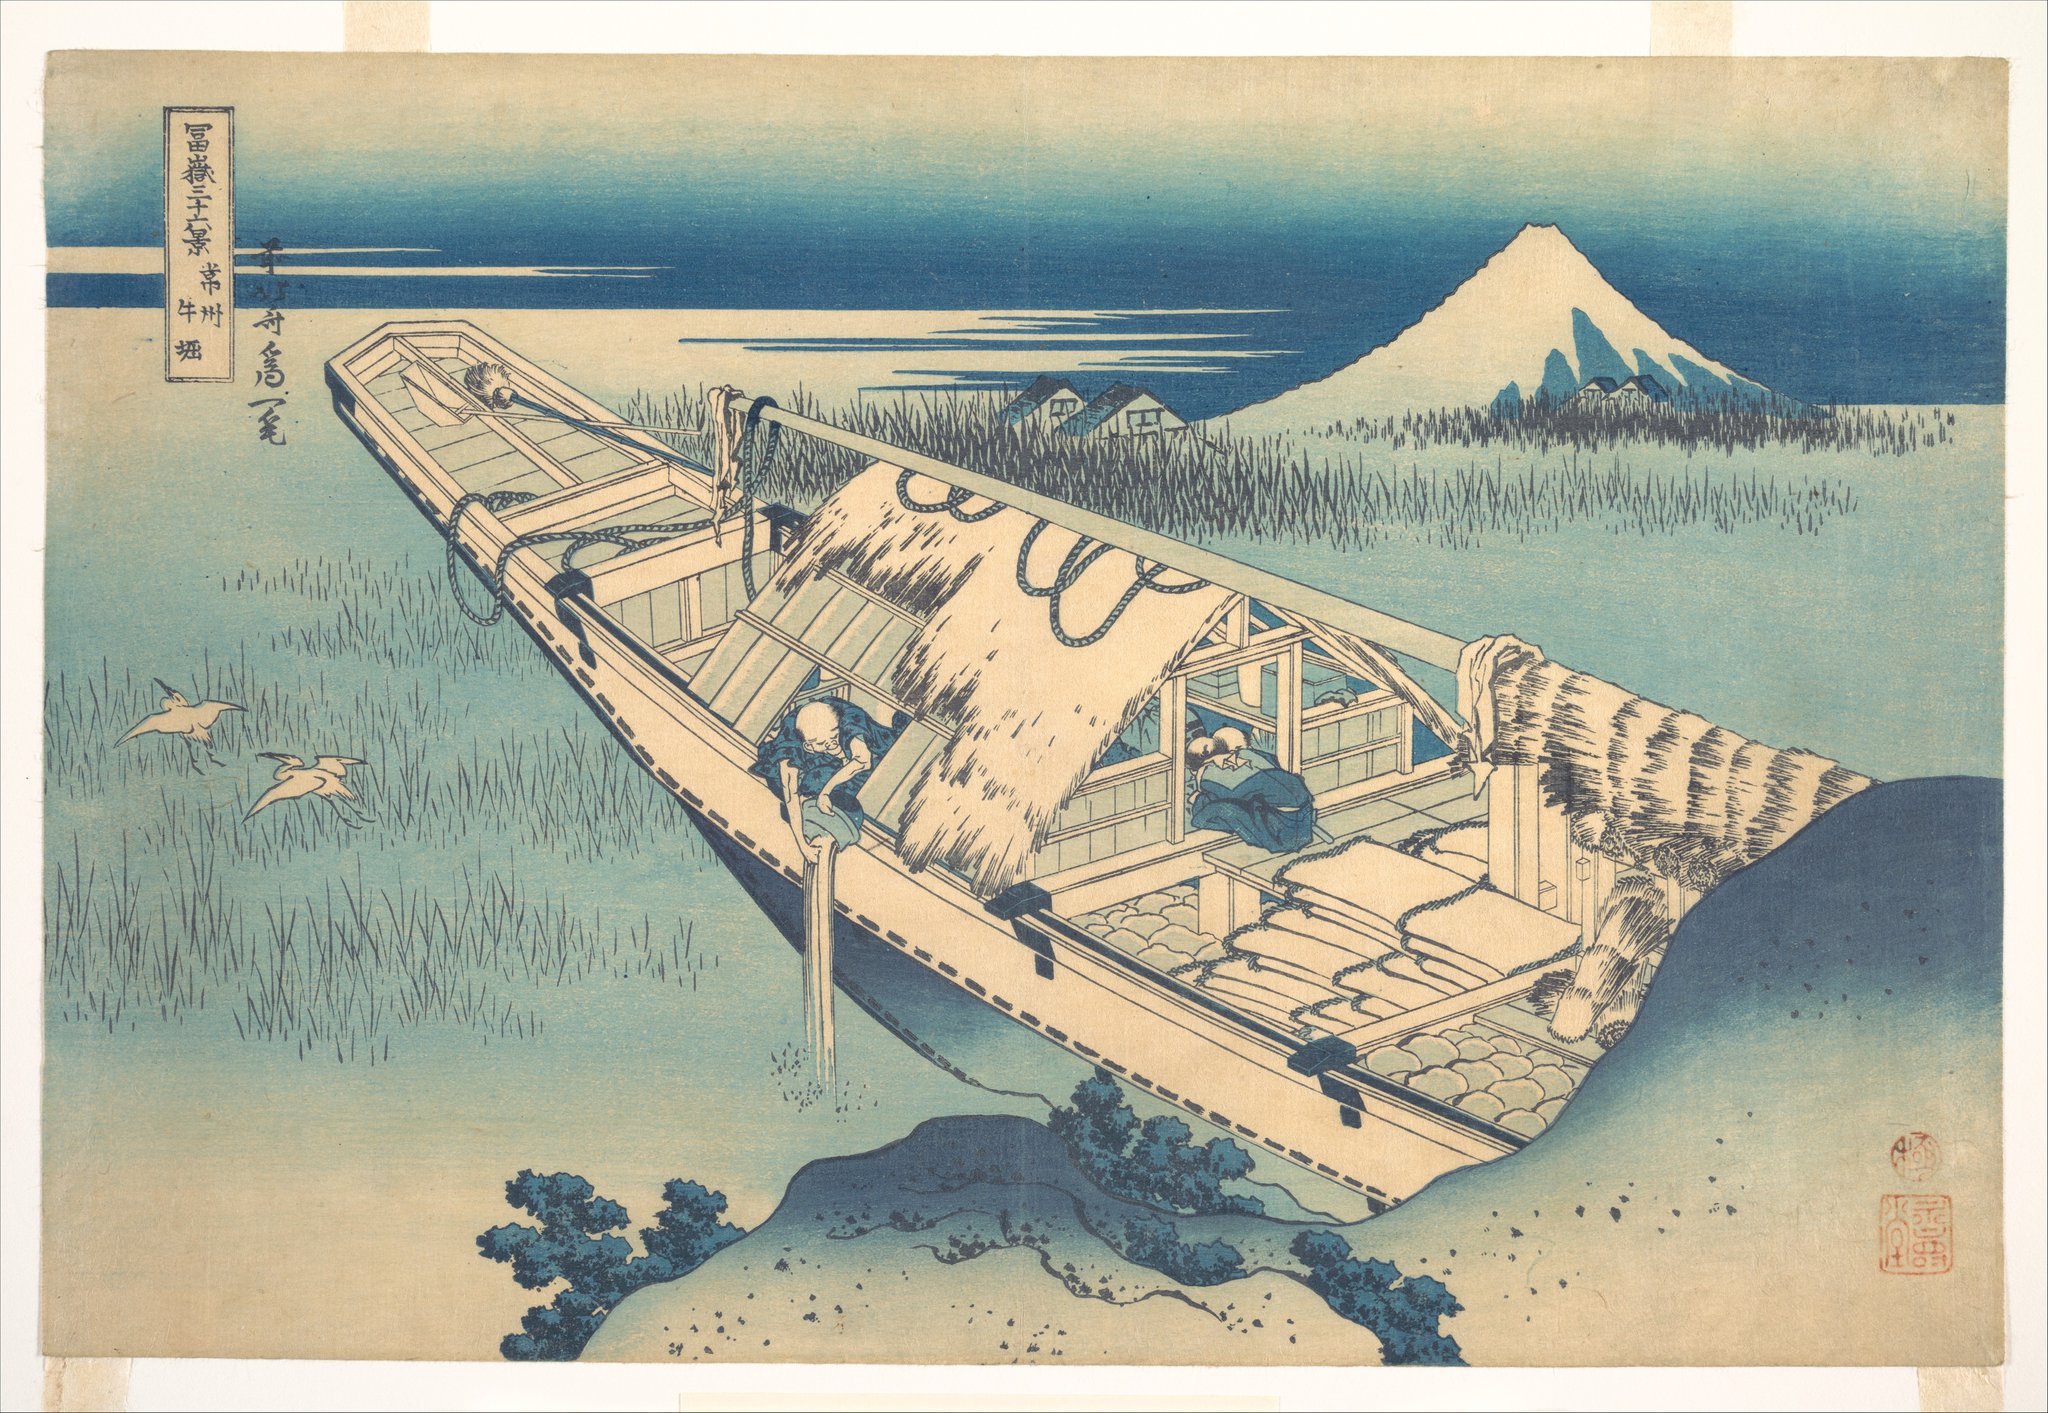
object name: woodblock print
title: Ushibori in Hitachi Province (Jōshū Ushibori), from the series Thirty-six Views of Mount Fuji (Fugaku sanjūrokkei)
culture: japanese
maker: katsushika hokusai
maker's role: artist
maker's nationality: japanese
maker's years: 1760-1849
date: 1830-1832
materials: ink, paper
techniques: woodblock print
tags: birds,mountains,boats